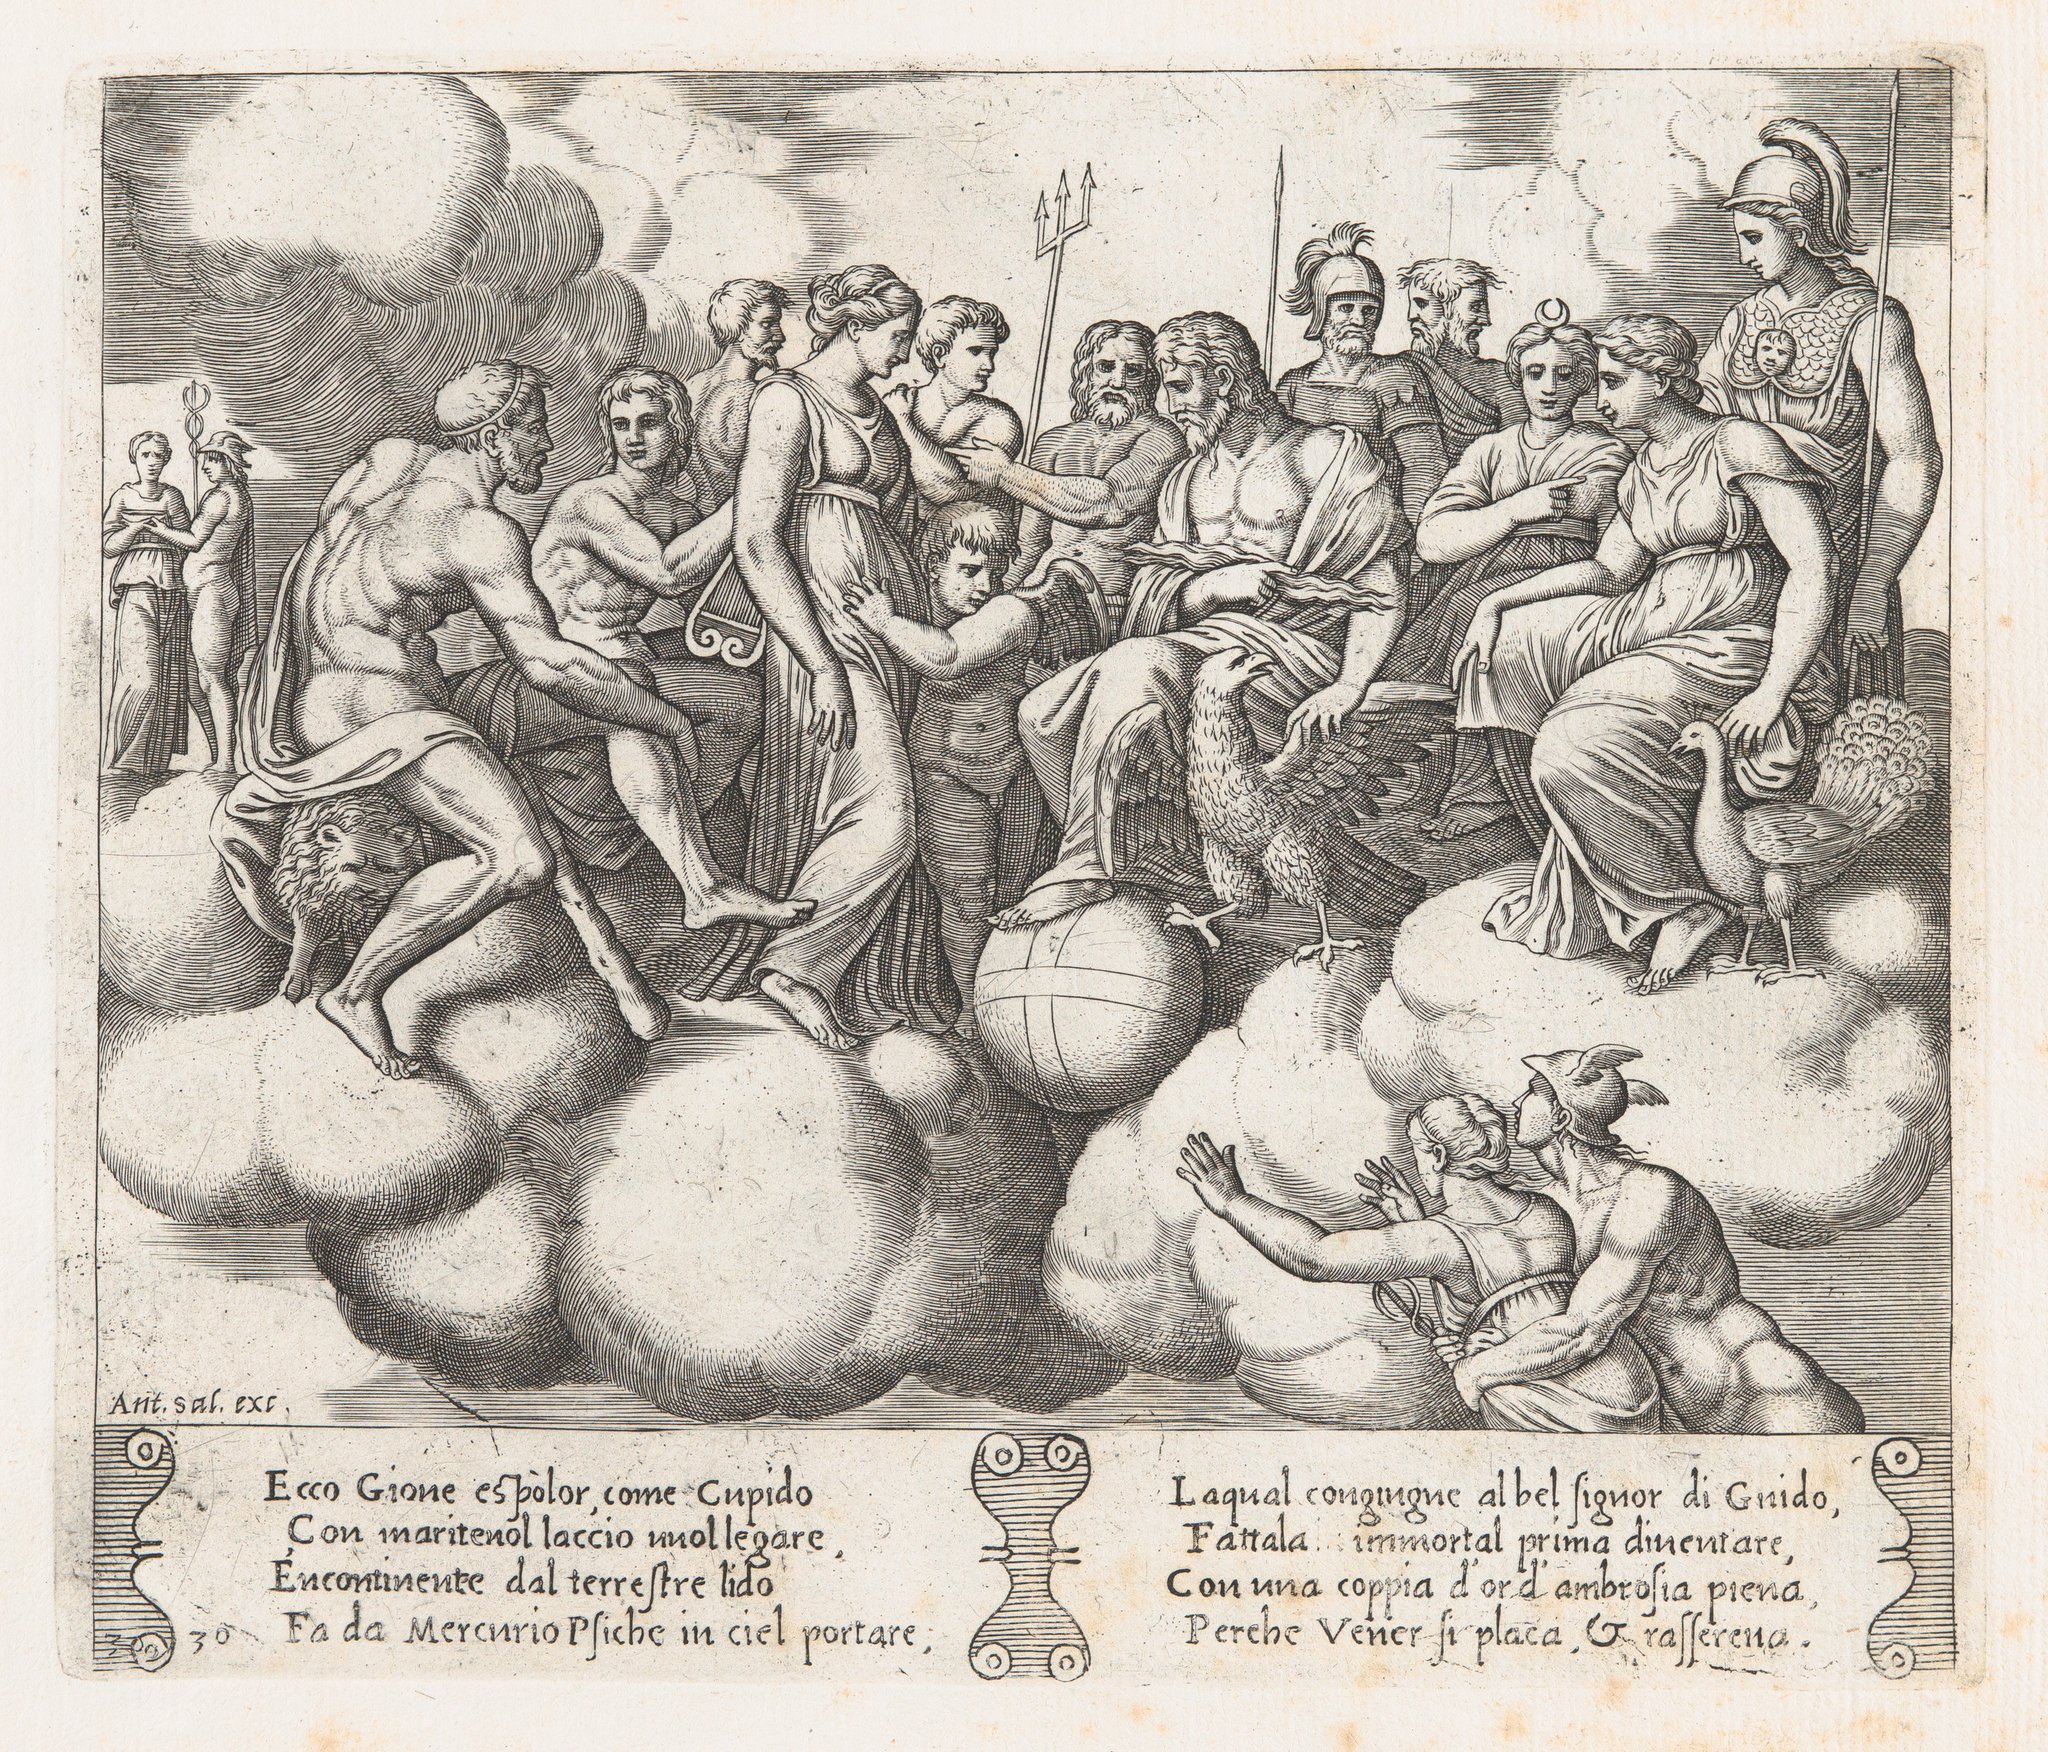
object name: print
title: Plate 30: Venus and Cupid pleading their case before Jupiter and other Gods with Mercury transporting Psyche to the heavens at lower right, from "The Story of Cupid and Psyche as told by Apuleius"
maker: master of the die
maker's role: artist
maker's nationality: italian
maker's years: 1525-1560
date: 1530-1560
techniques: engraving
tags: cupid,psyche,mercury,venus